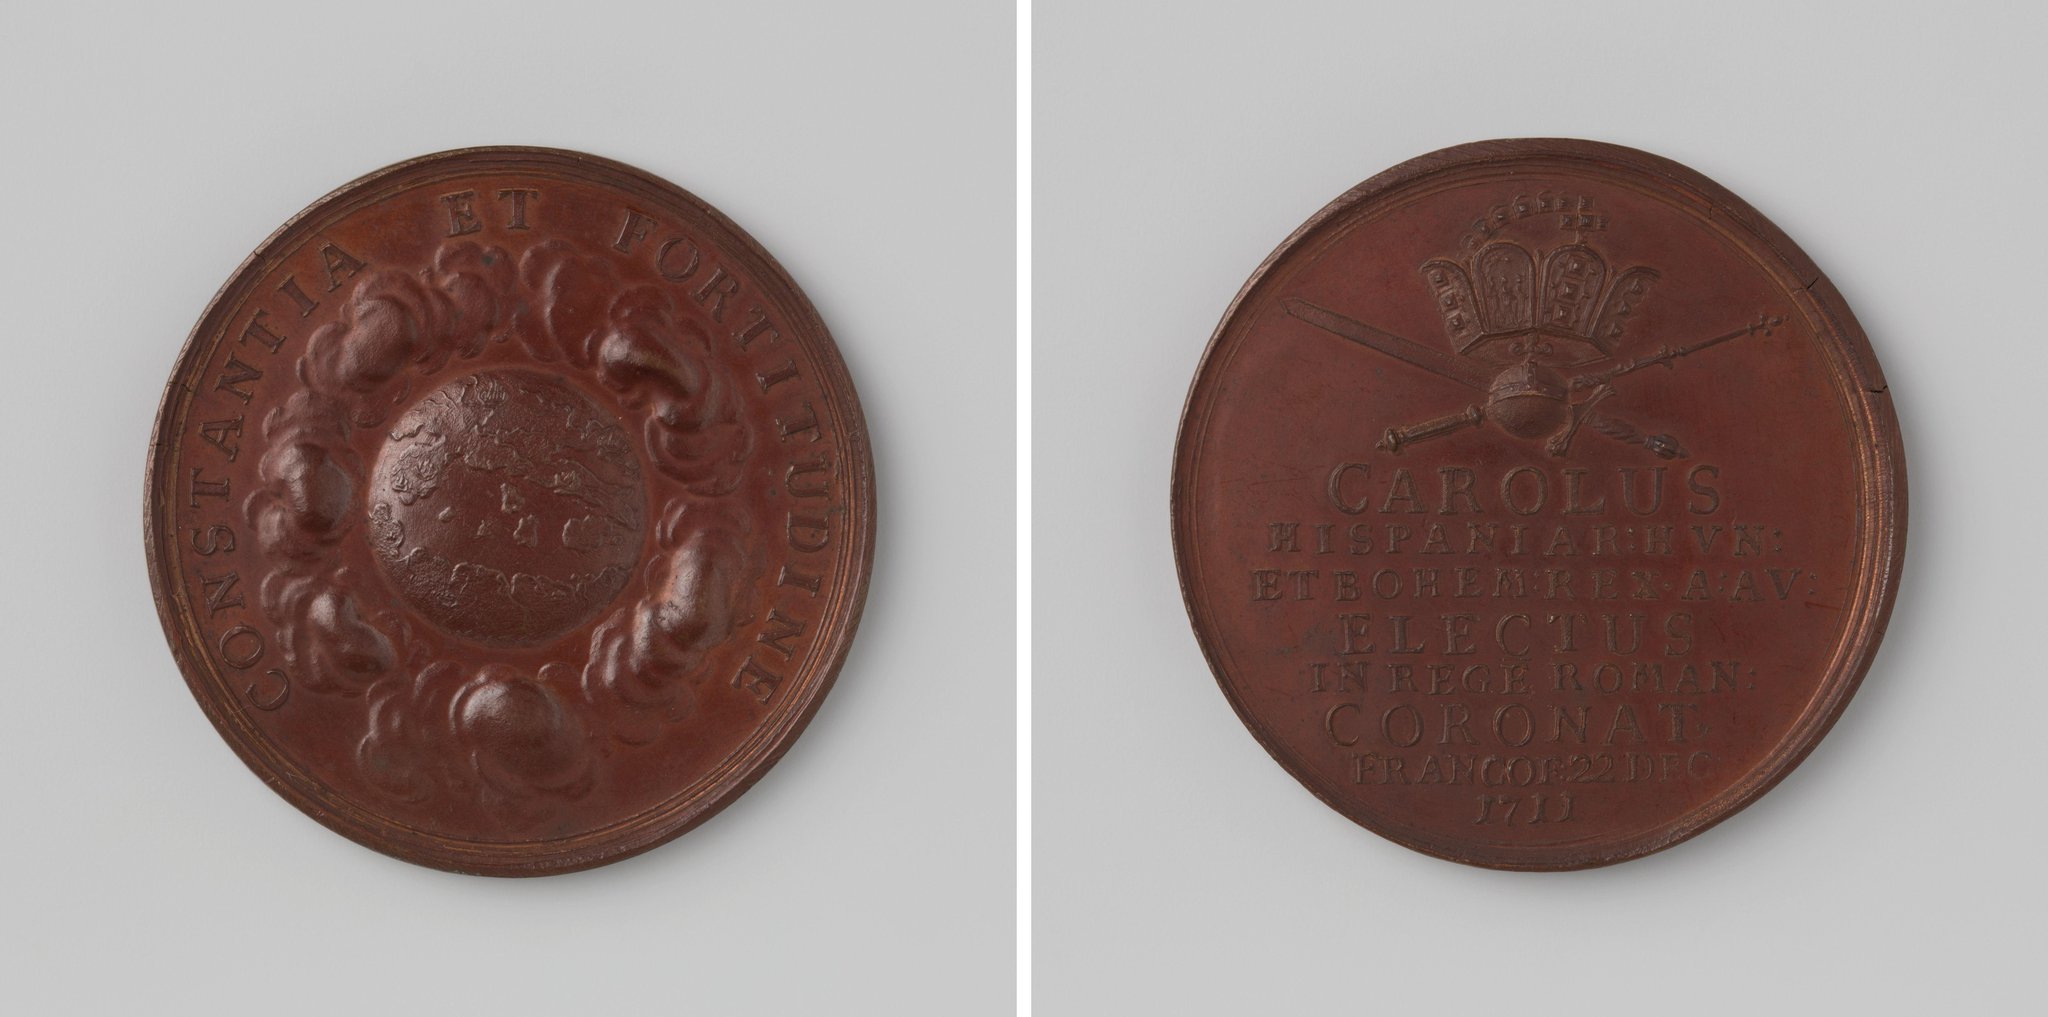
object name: history medal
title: Karel VI gekozen tot Duits keizer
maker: philipp christoph becker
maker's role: die cutter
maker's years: 1674-1743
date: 1711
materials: copper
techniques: striking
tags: vienna, charles vi (holy roman emperor)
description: Koperen penning. Voorzijde: wereldbol binnen ring van wolken en omschrift. Keerzijde: opschrift onder rijksappel, scepter, zwaard en kroon